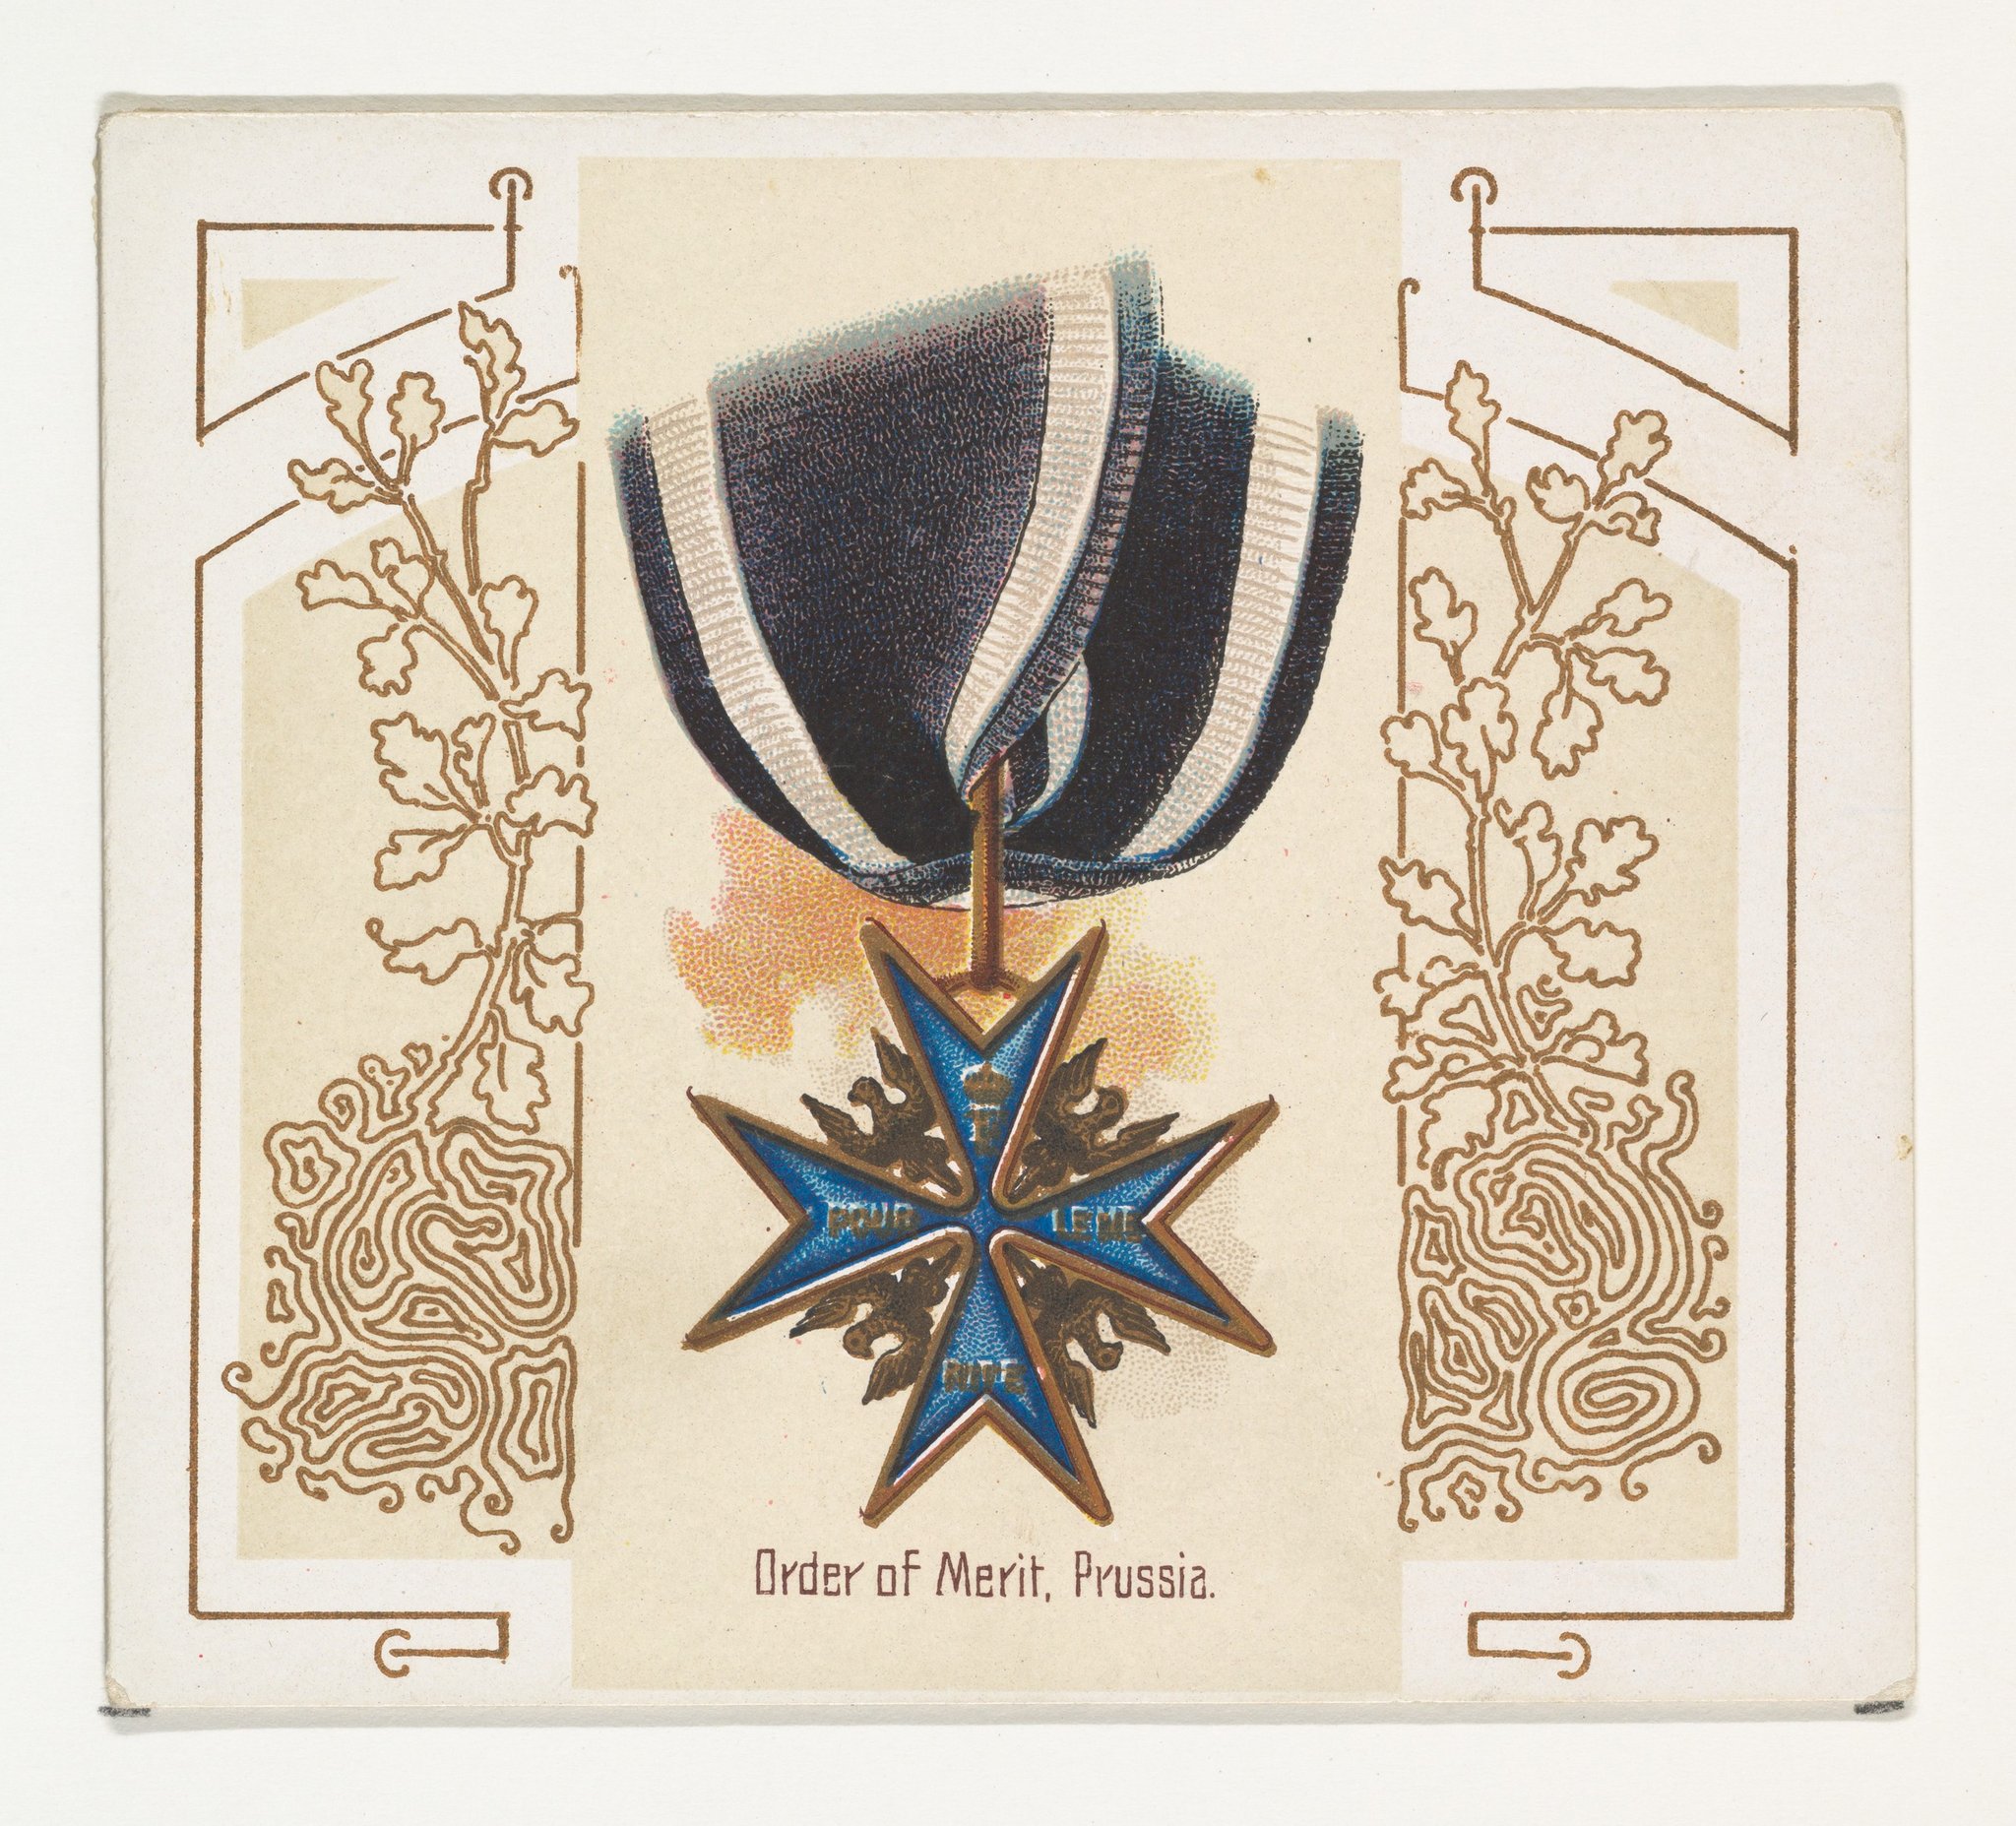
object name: print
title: Order of Merit, Prussia, from the World's Decorations series (N44) for Allen & Ginter Cigarettes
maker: allen & ginter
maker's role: publisher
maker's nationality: american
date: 1890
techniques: color lithograph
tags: medals